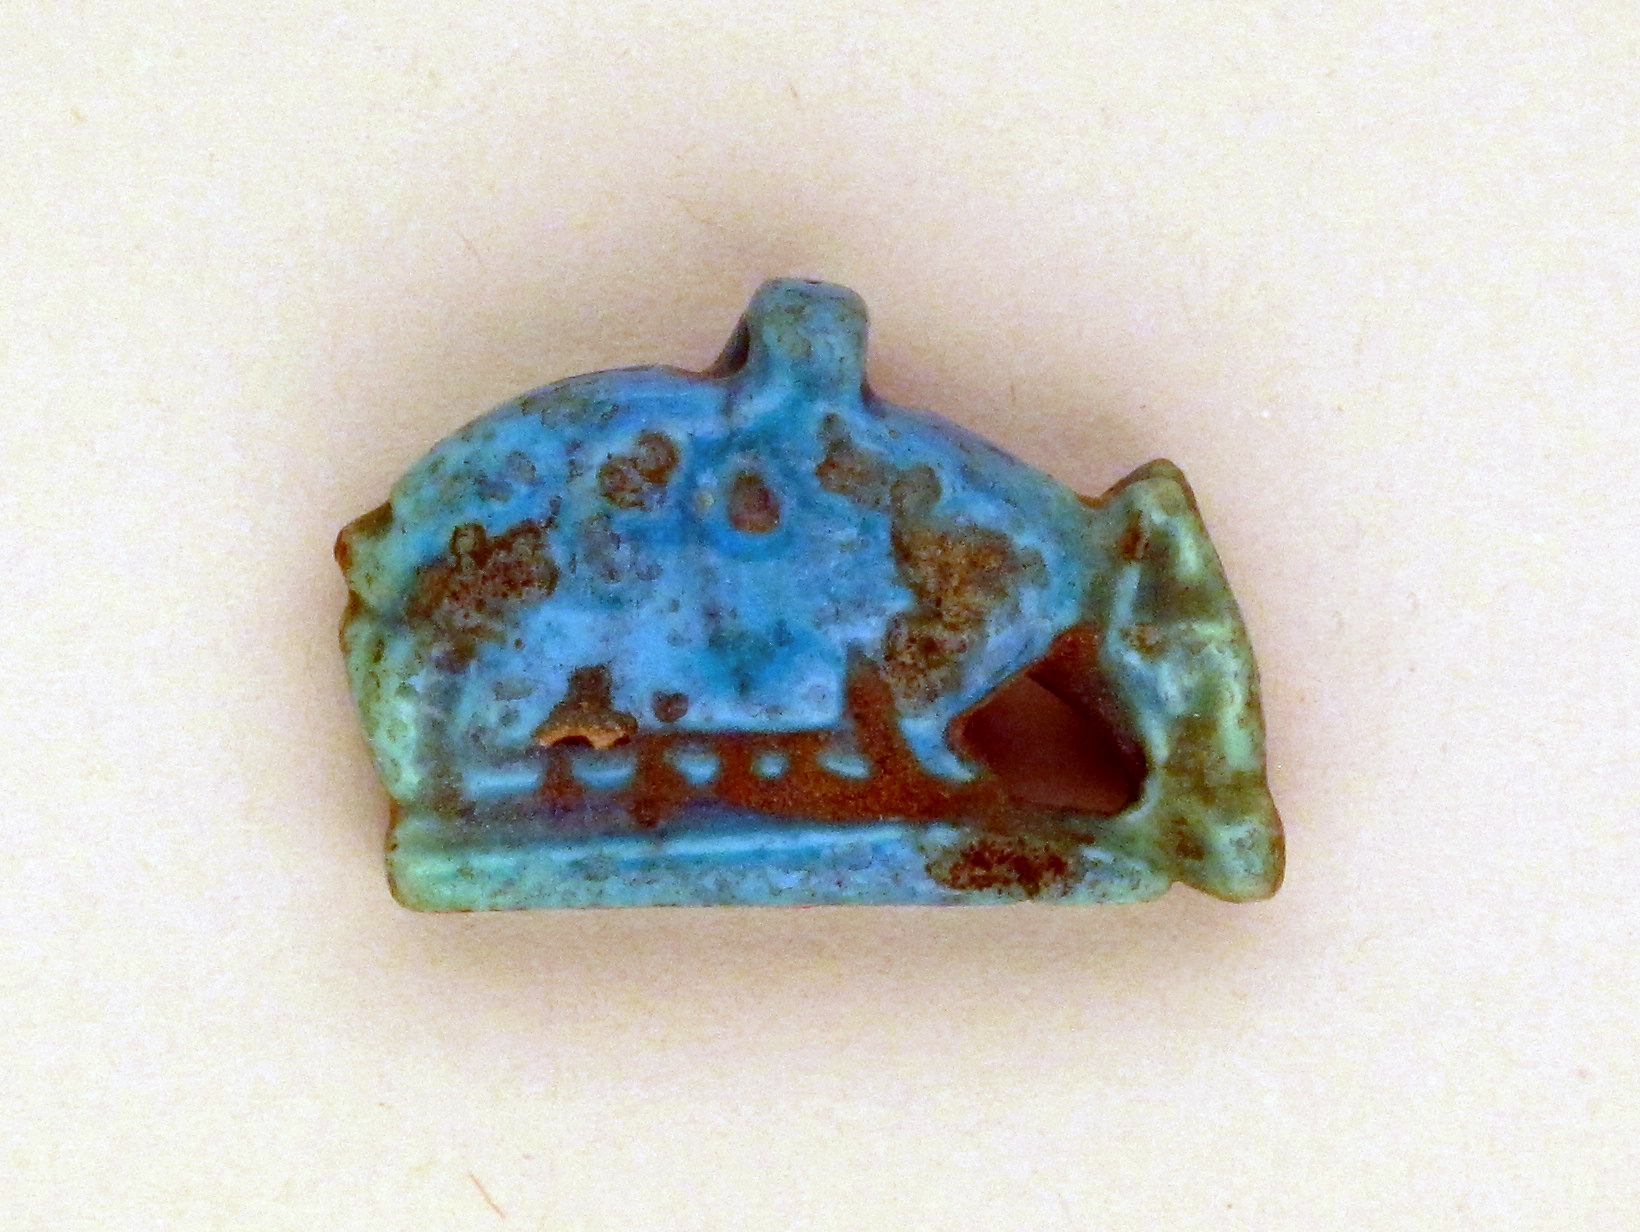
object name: amulet, sow with piglet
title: Faience amulet of a sow with piglets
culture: egyptian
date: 1050-900 BCE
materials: faience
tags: animals